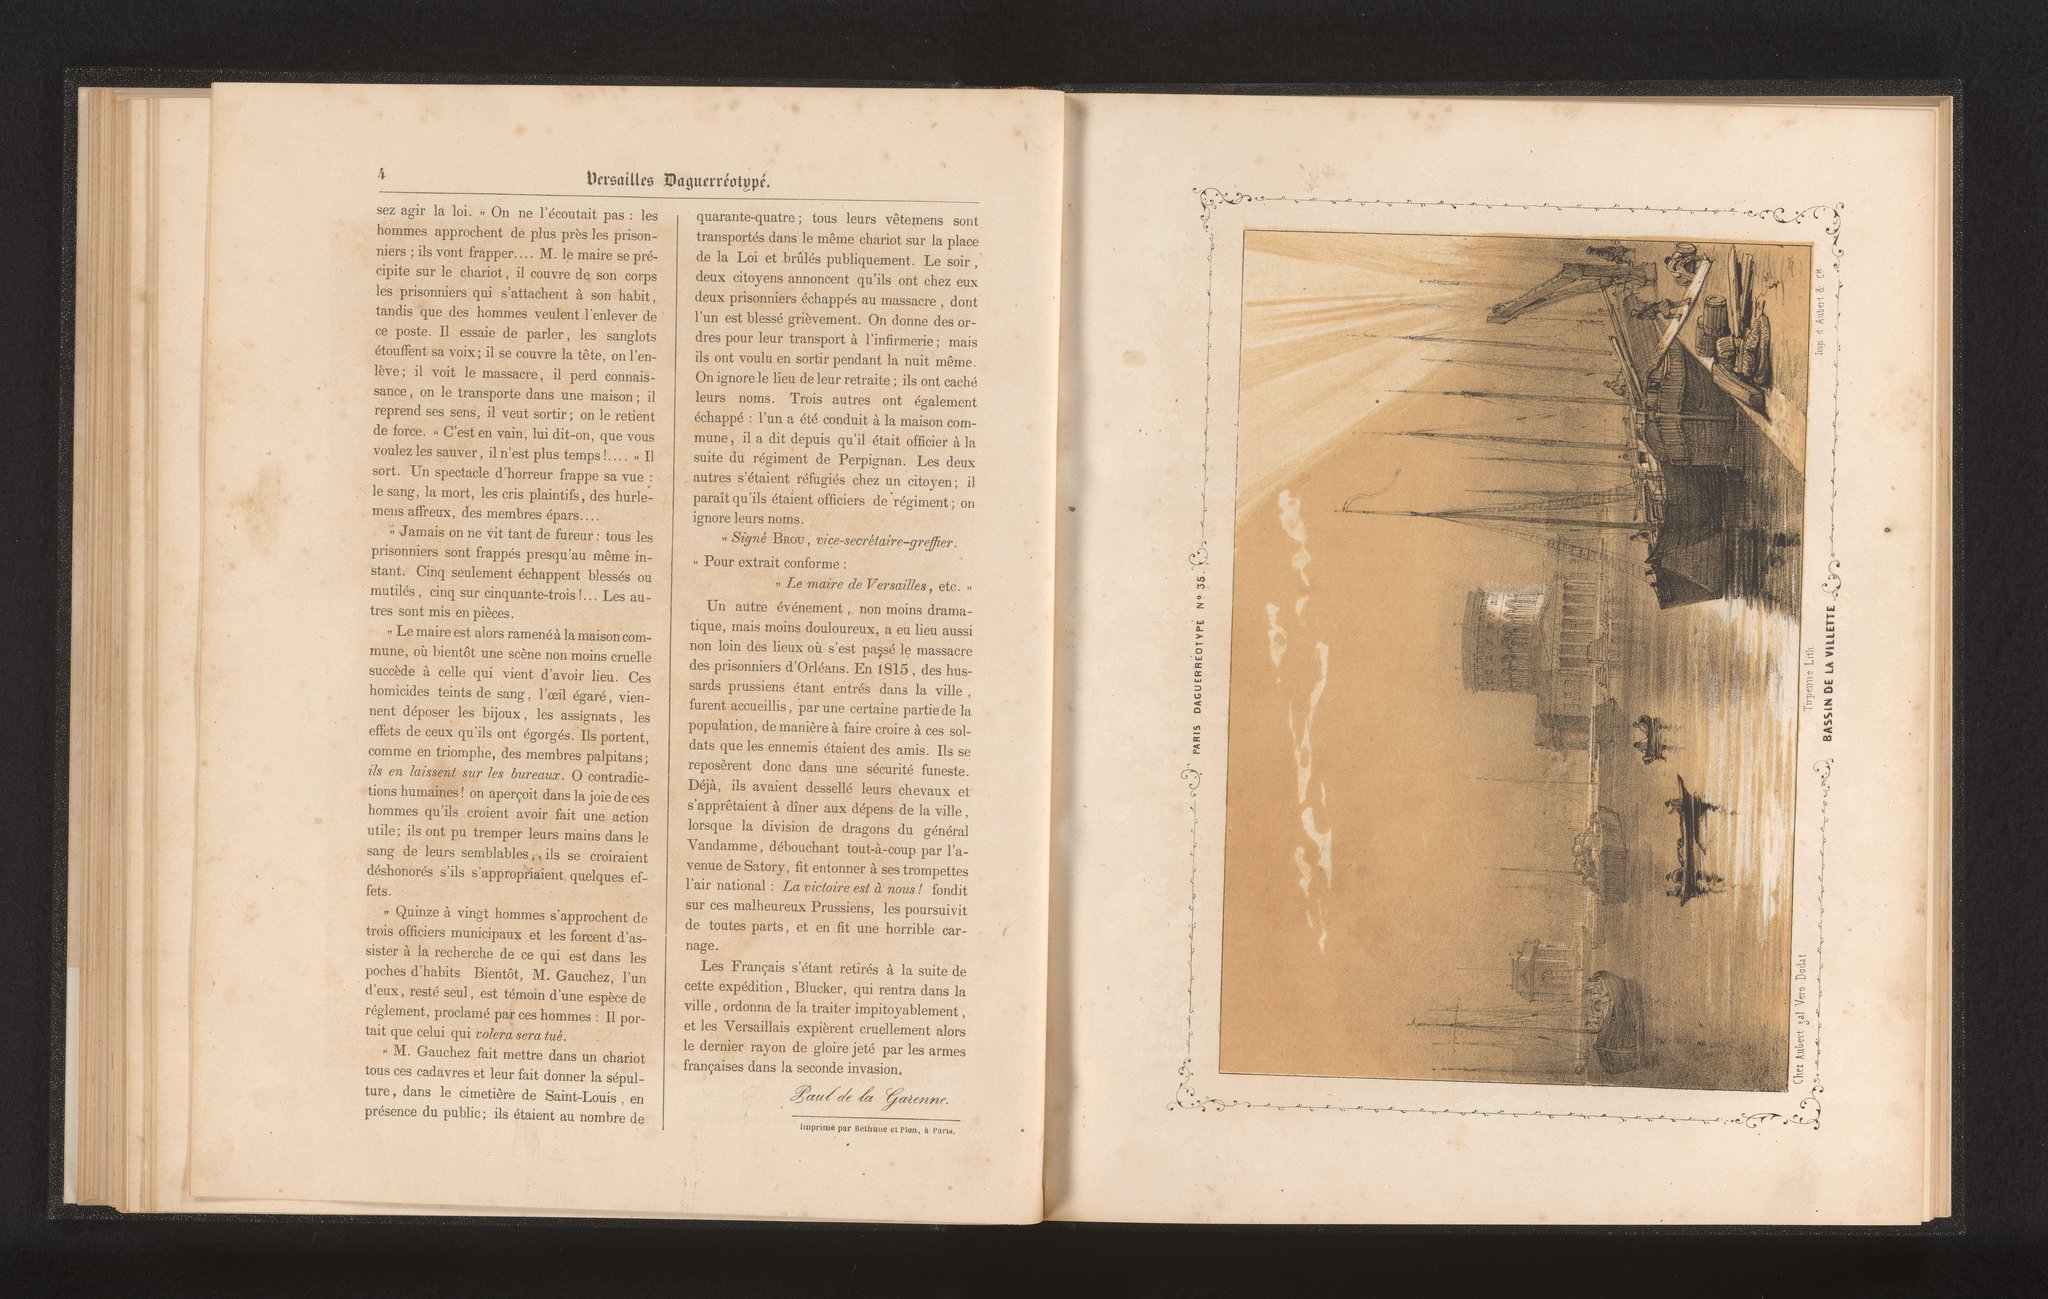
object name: page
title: Bassin de la Villette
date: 1839-1840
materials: paper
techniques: tone lithography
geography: paris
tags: canals, waters (in city)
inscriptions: inscription: ‘PARIS DAGUERRÉOTYPÉ No. 35.’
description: Prent op honderdnegenendertigste ongenummerde pagina.